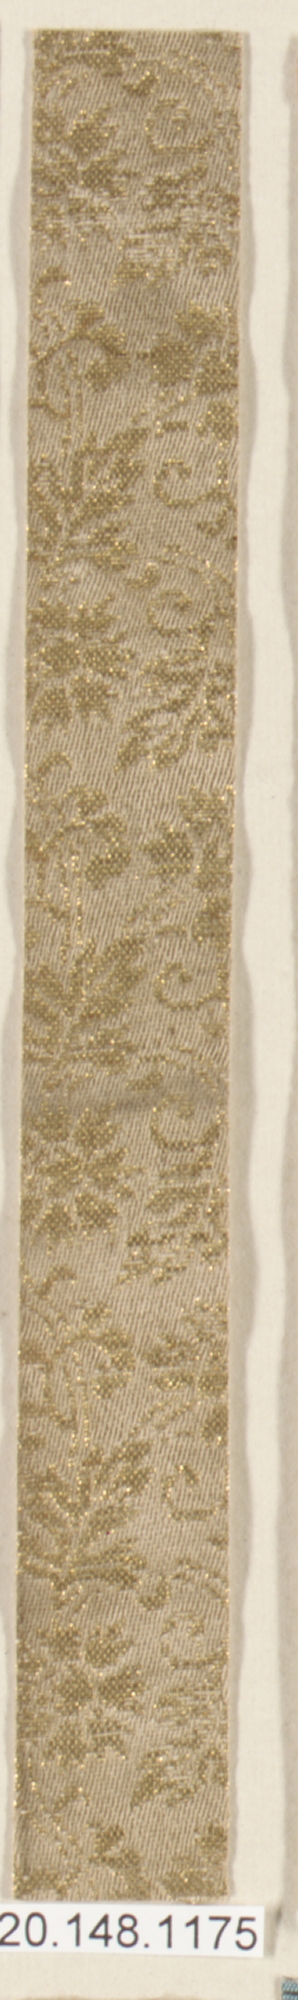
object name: piece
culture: japanese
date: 1601-1700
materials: silk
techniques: compound weave